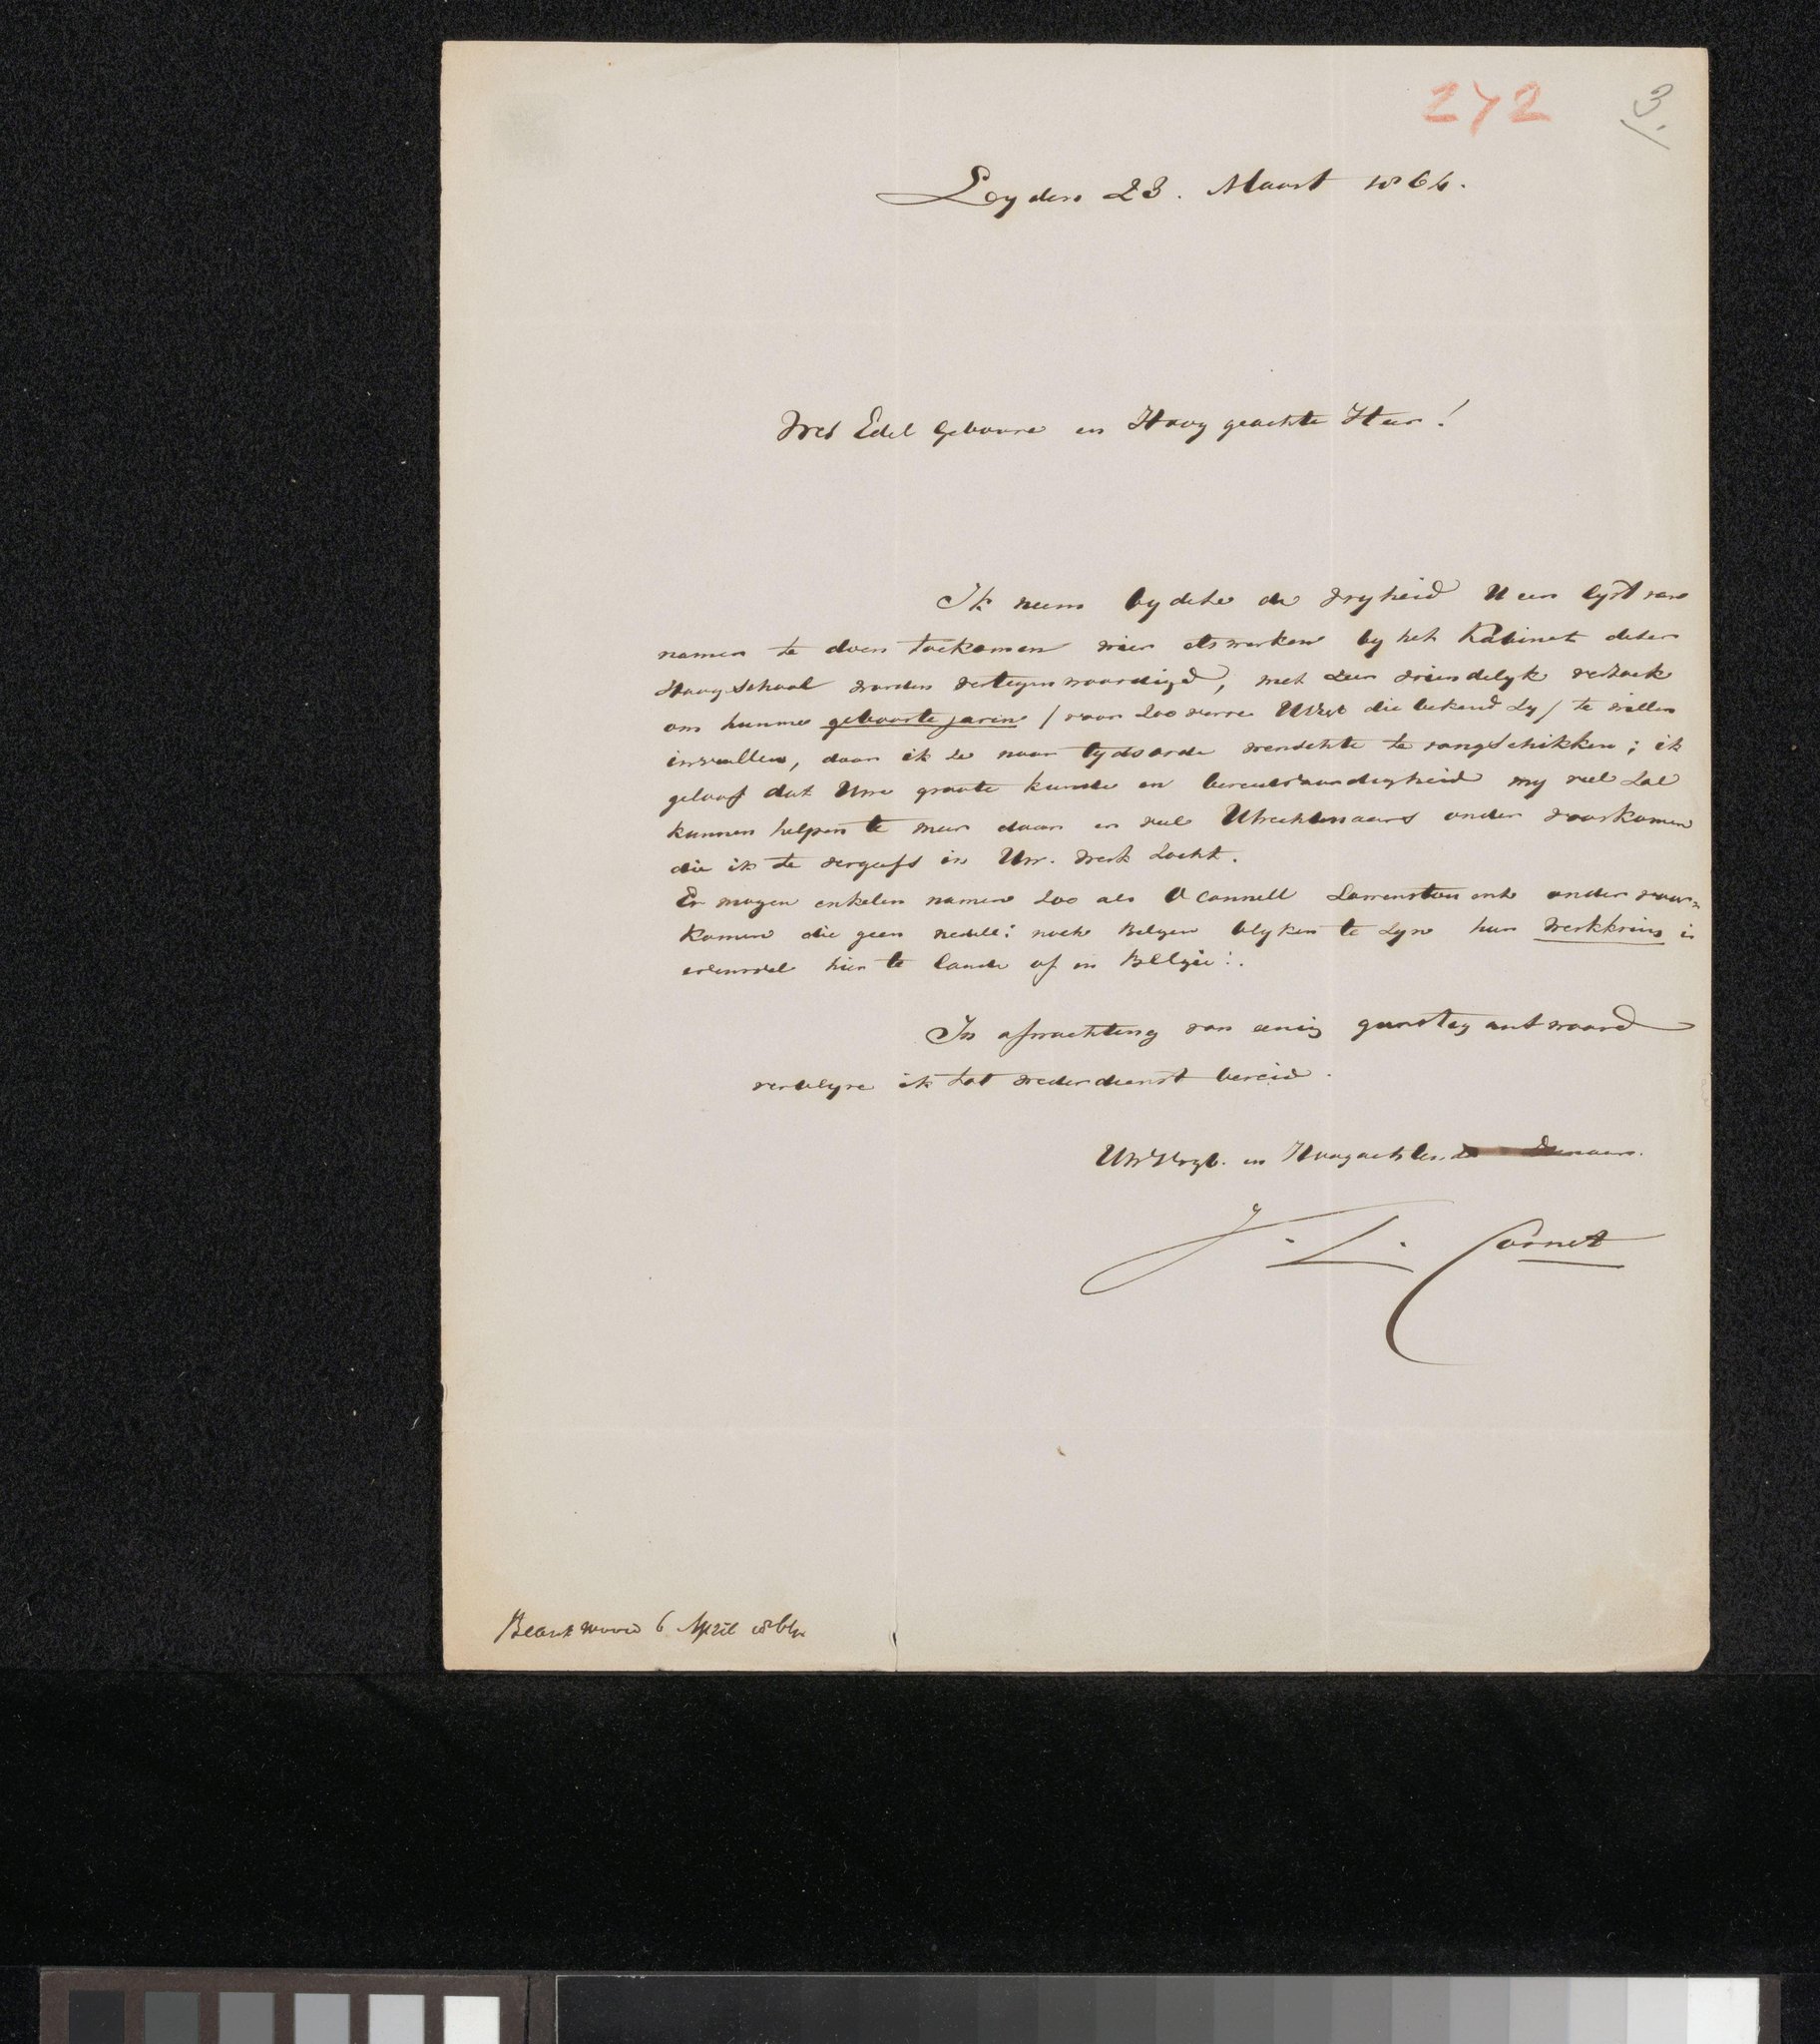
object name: letter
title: Brief aan anoniem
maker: jacobus ludovicus cornet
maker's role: draughtsman, print maker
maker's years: 1815-1882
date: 1864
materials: ink, paper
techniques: pen, writing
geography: leiden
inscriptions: collector's mark: Lugt 2233